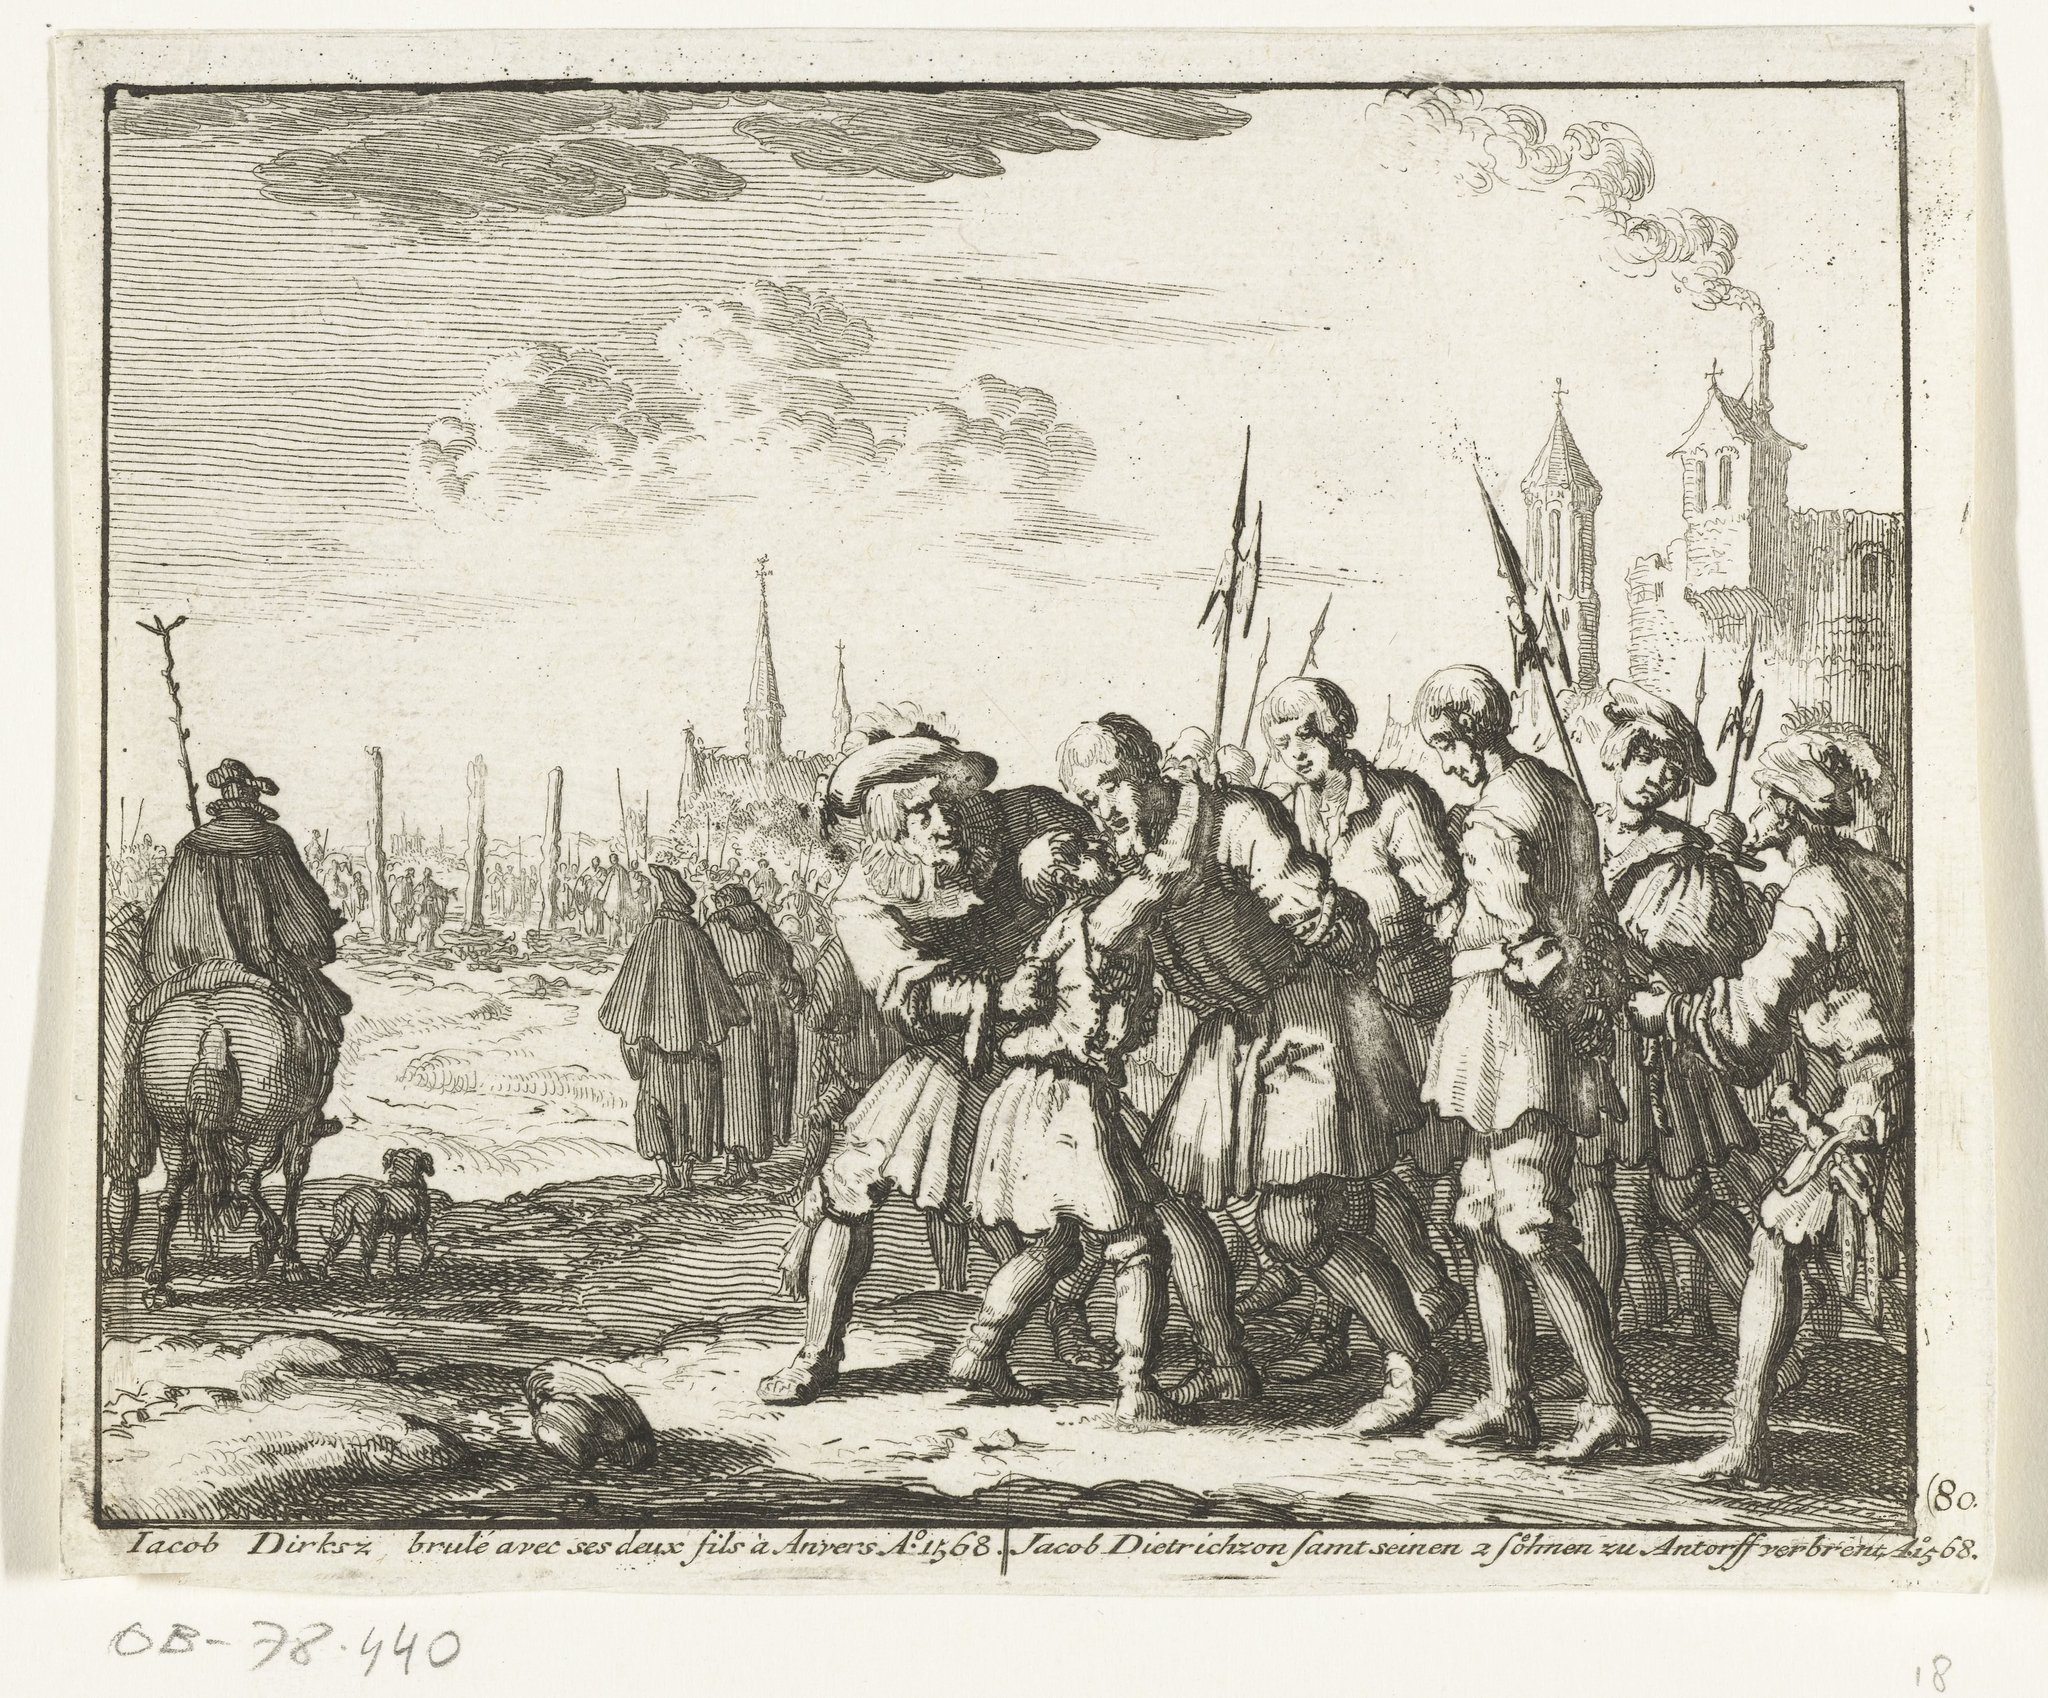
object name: print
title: Iacob Dirksz brulé aves ses deux fils à Anvers Ao. 1568 / Jacob Dietrichzon samt seinen 2 söhnen zu Antorff verbrent, Ao. 1568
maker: jan luyken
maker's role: draughtsman, print maker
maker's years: 1649-1712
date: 1683-1685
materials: paper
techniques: etching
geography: northern netherlands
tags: antwerp, violent death by burning at the stake; pyre, persecution of heretics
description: De prenten in deze tweede staat gebruikt als illustratie voor: Theatre des martyrs, depuis la mort de J. Christ jusqu'à present (...). = Schau-buhne der Martyrer, P. van der Aa, Leiden ca. 1715, nr. 80. De prenten zijn oorspronkelijk vervaardigd voor en eerst gebruikt in: T.J. van Bragt, Het bloedig tooneel, of Martelaers spiegel der doops-gesinde of weereloose christenen, 1685.